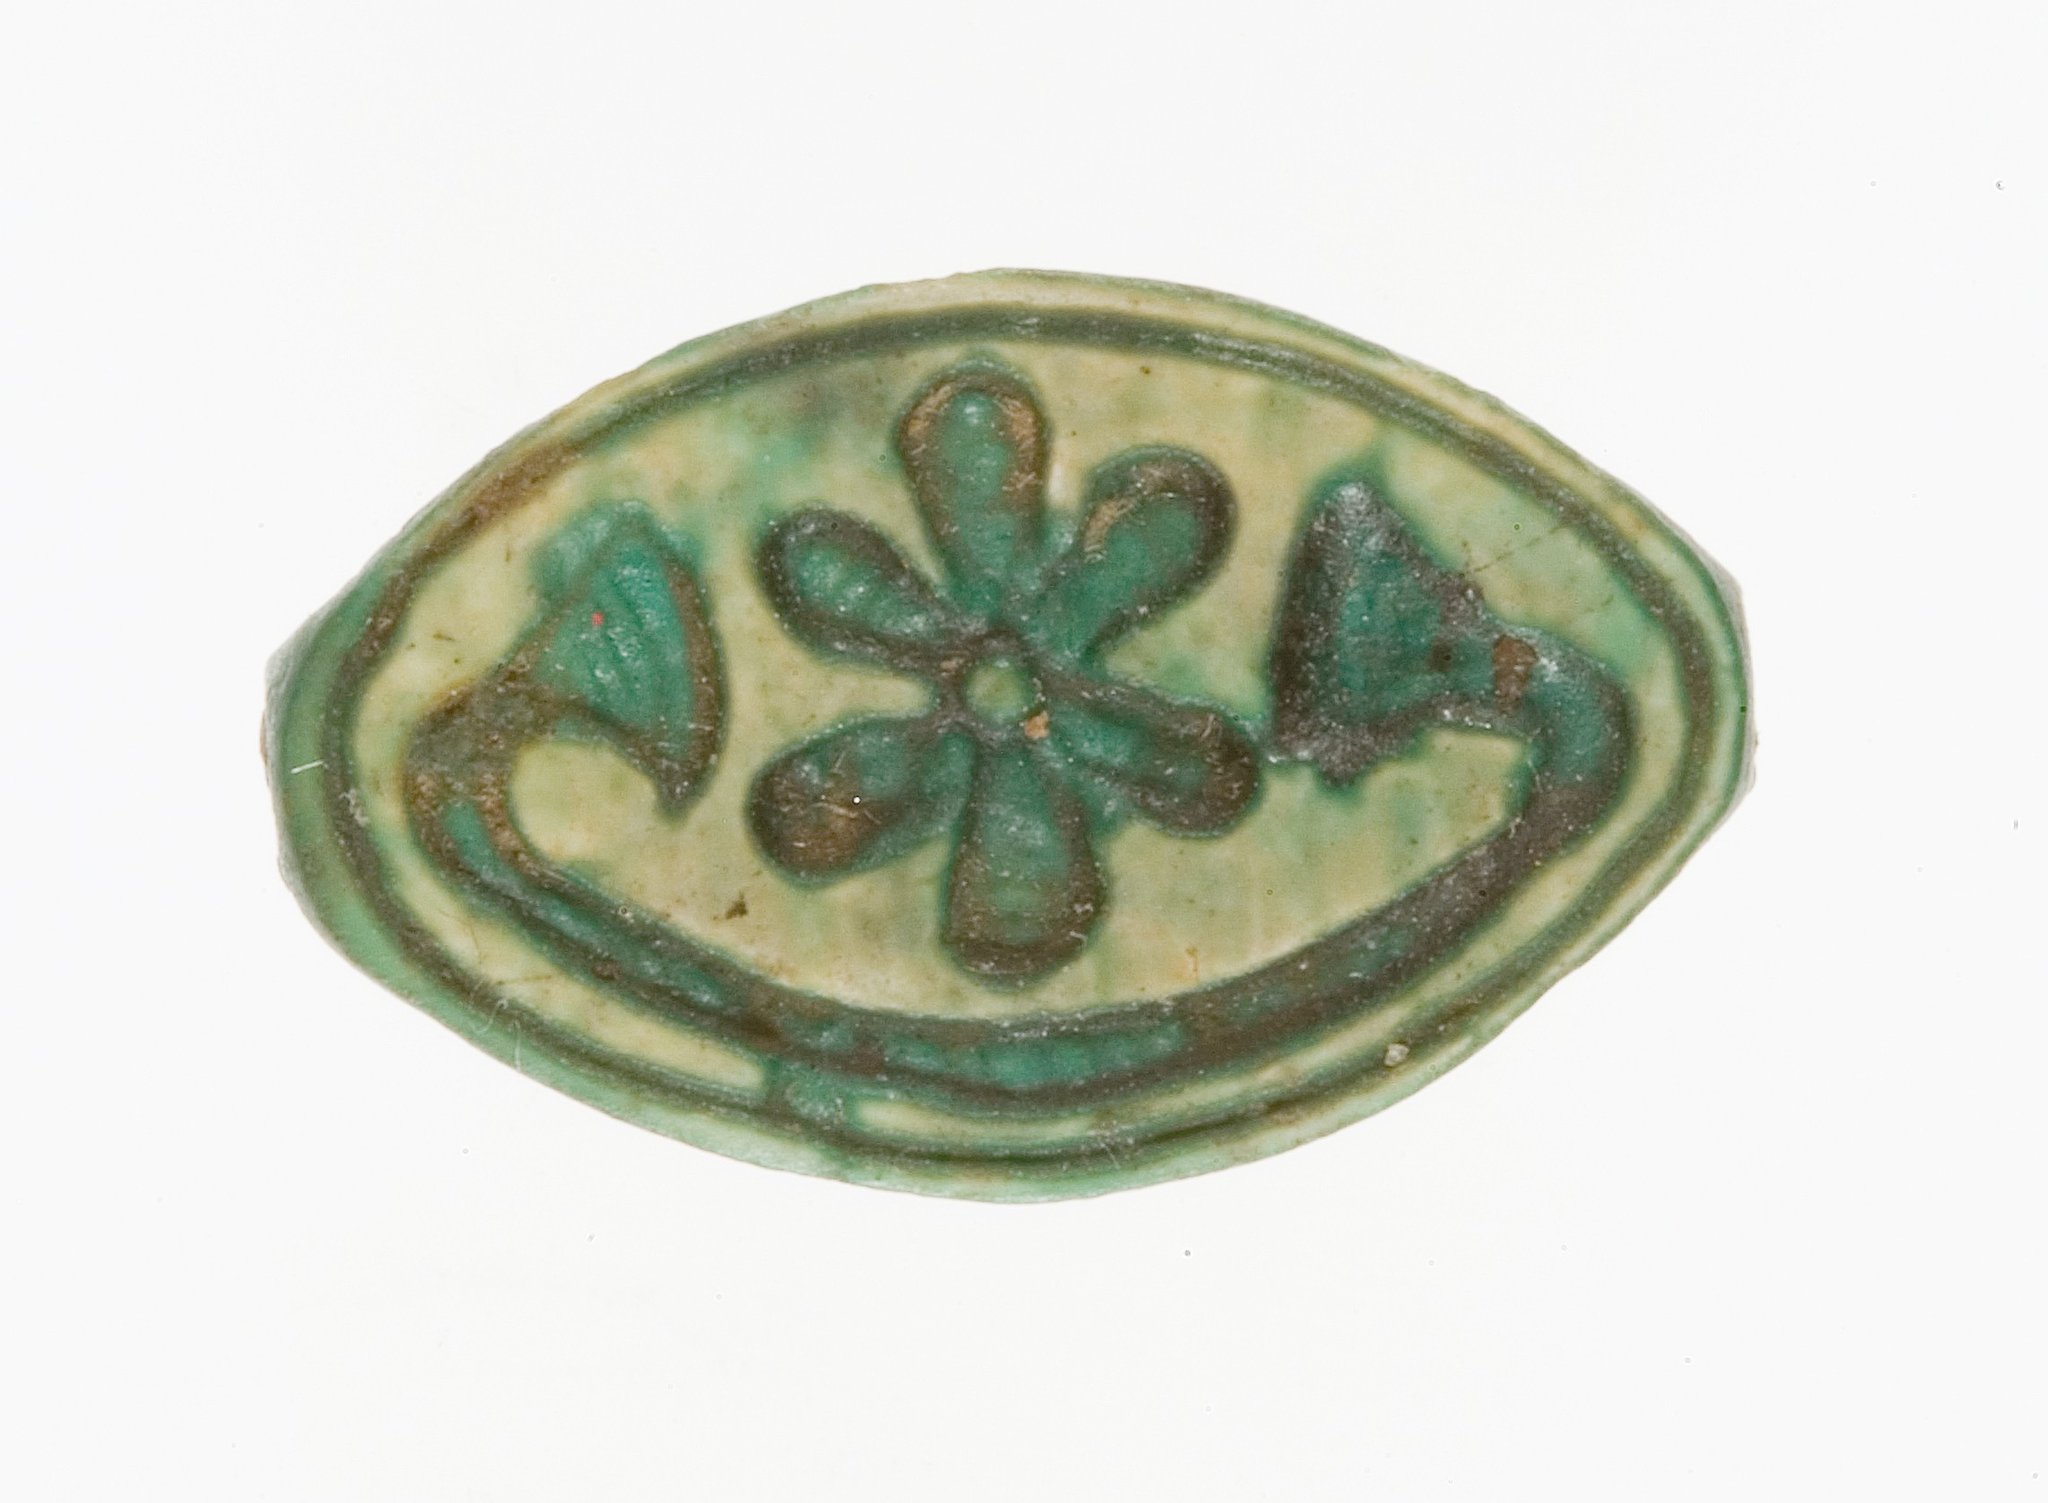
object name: cowroid, hatshepsut fd, papyrus boat, rosette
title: Cowroid Seal Amulet Inscribed with a Decorative Motif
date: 1479-1458 BCE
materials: stone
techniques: glazing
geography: egypt